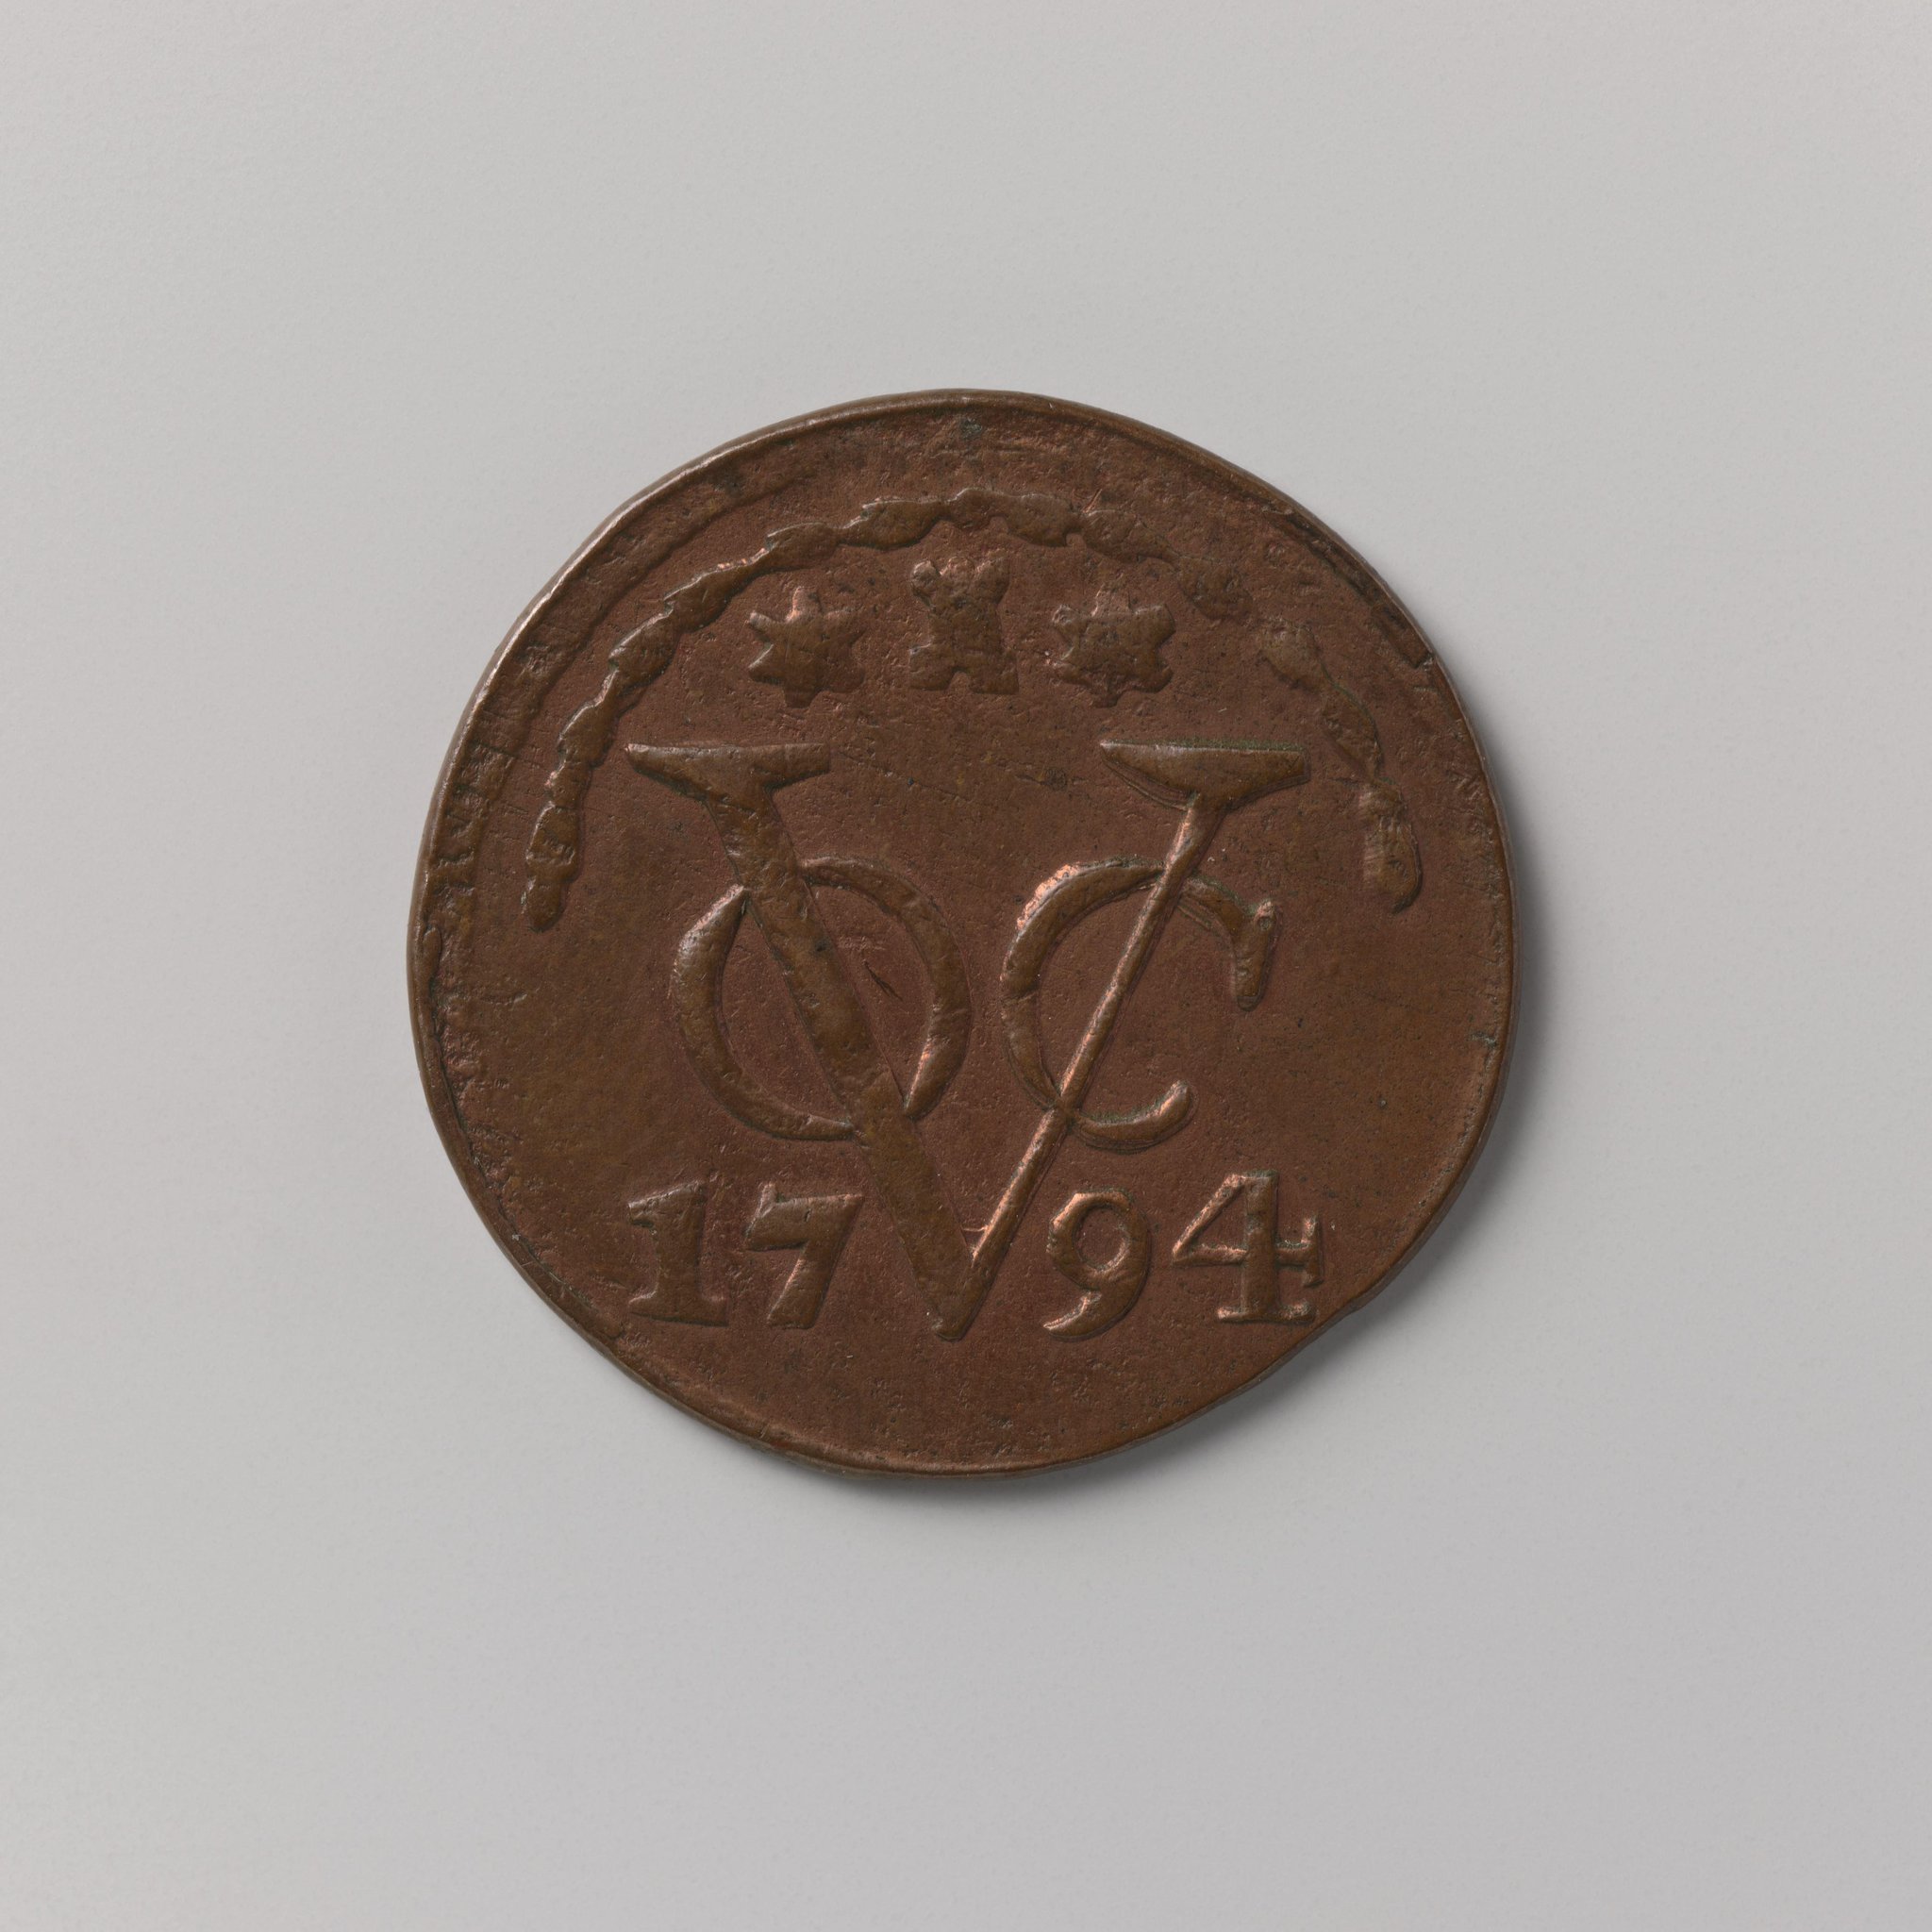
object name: coin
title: Duit van de VOC uit Zeeland, 1794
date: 1794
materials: copper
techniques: striking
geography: middelburg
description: Koperen munt. Voorzijde: driehoekig ingebogen en in een punt uitlopend gekroond wapenschild van Zeeland. Keerzijde: monogram van de VOC, waarboven onder halve bladerkrans muntteken en waaronder jaartal. Gladde rand.